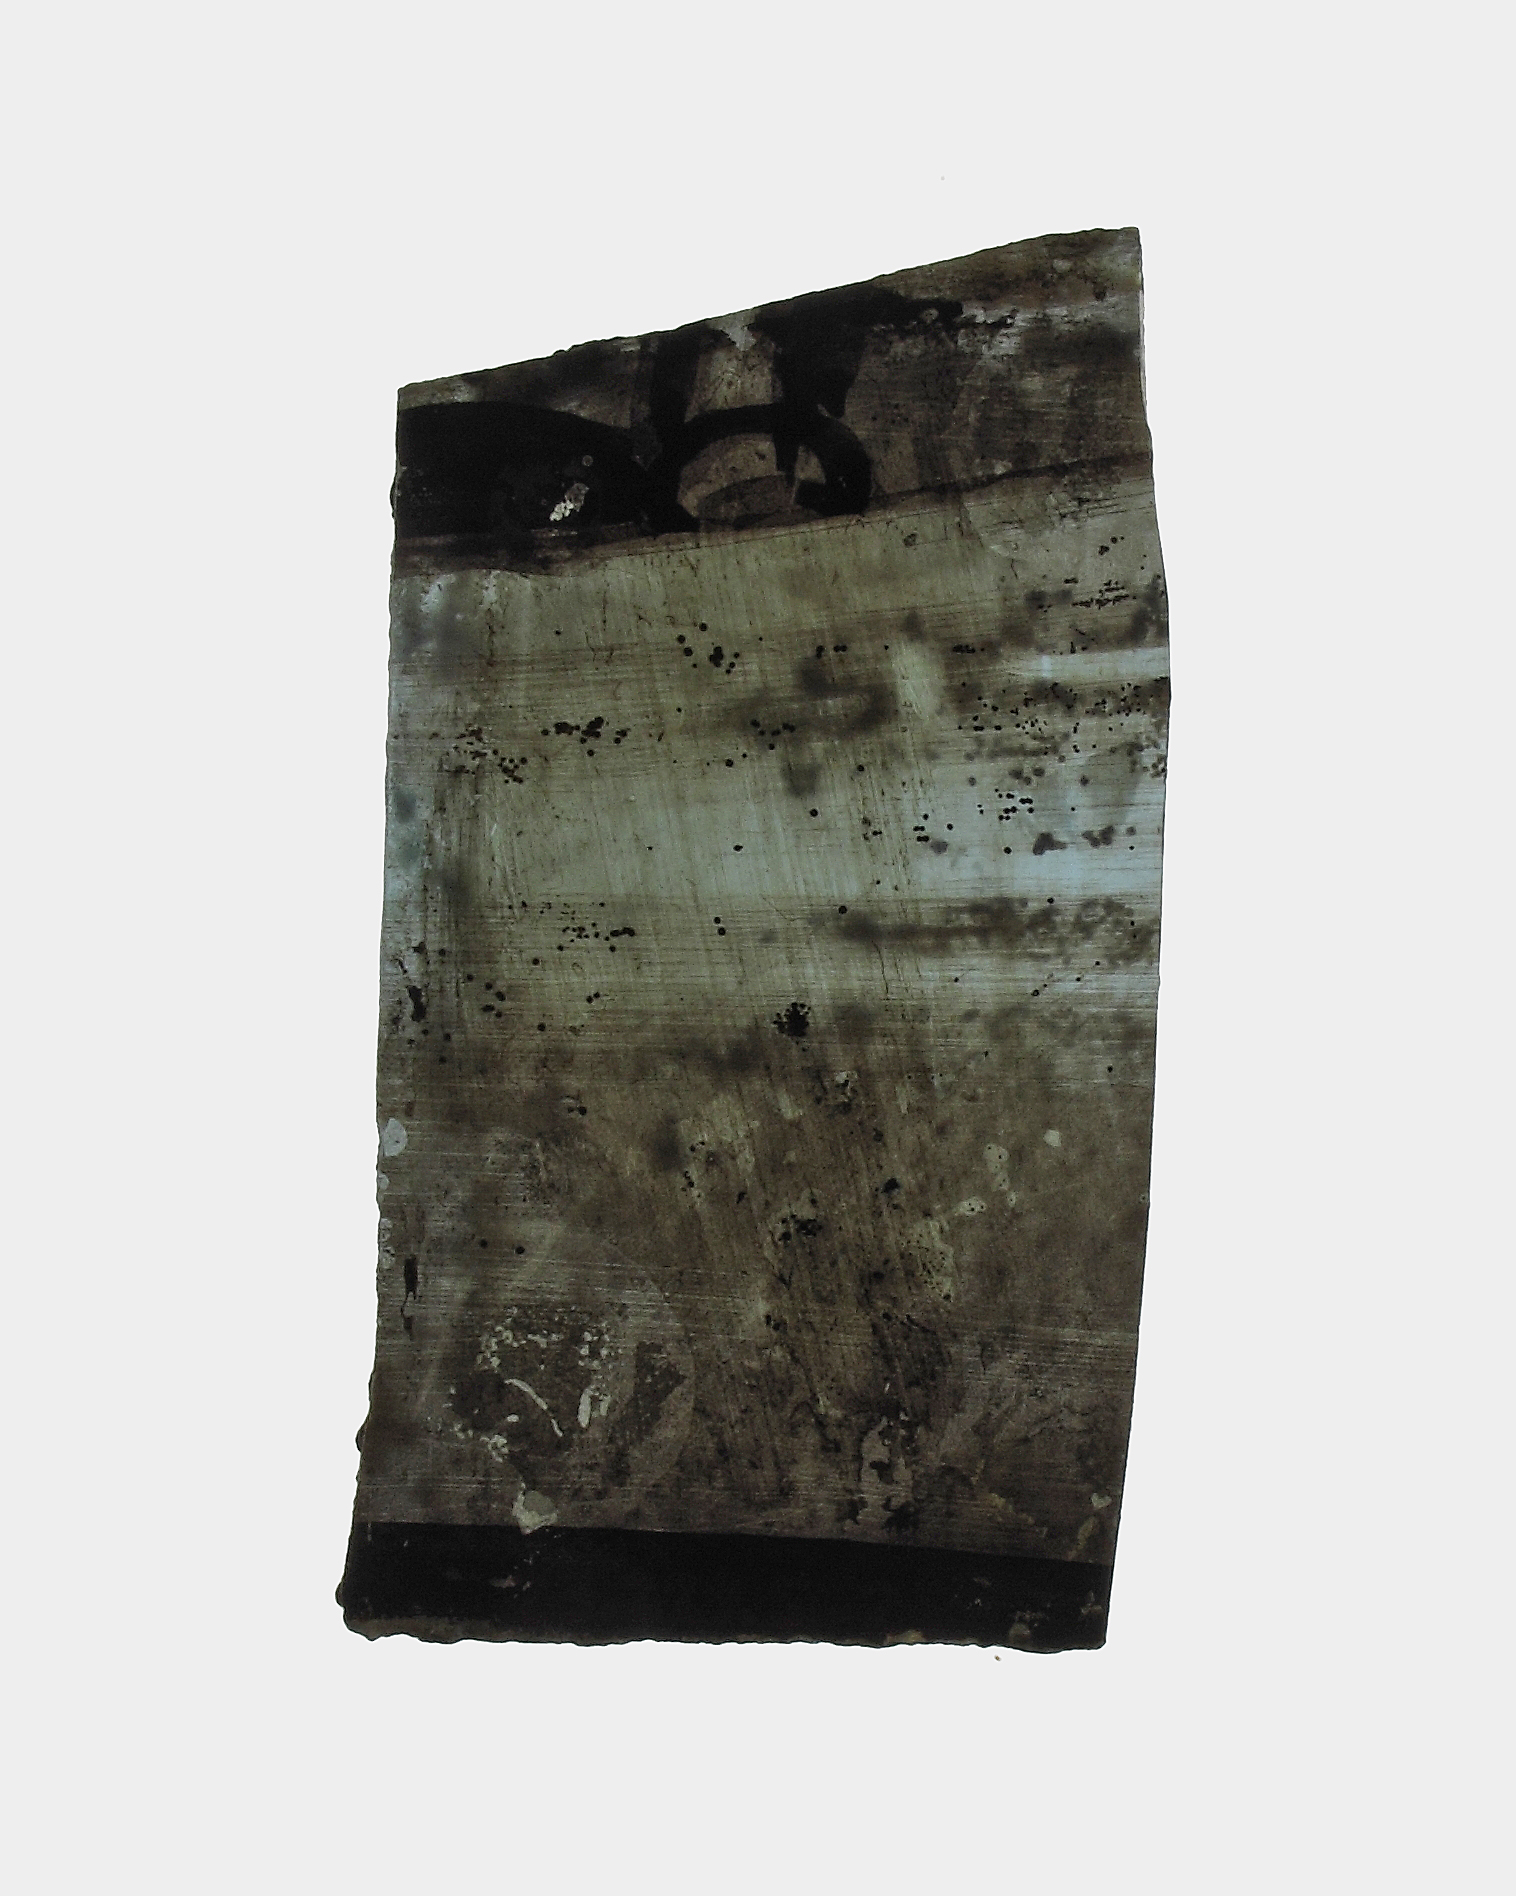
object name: fragment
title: Glass Fragment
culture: french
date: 1501-1600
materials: glass